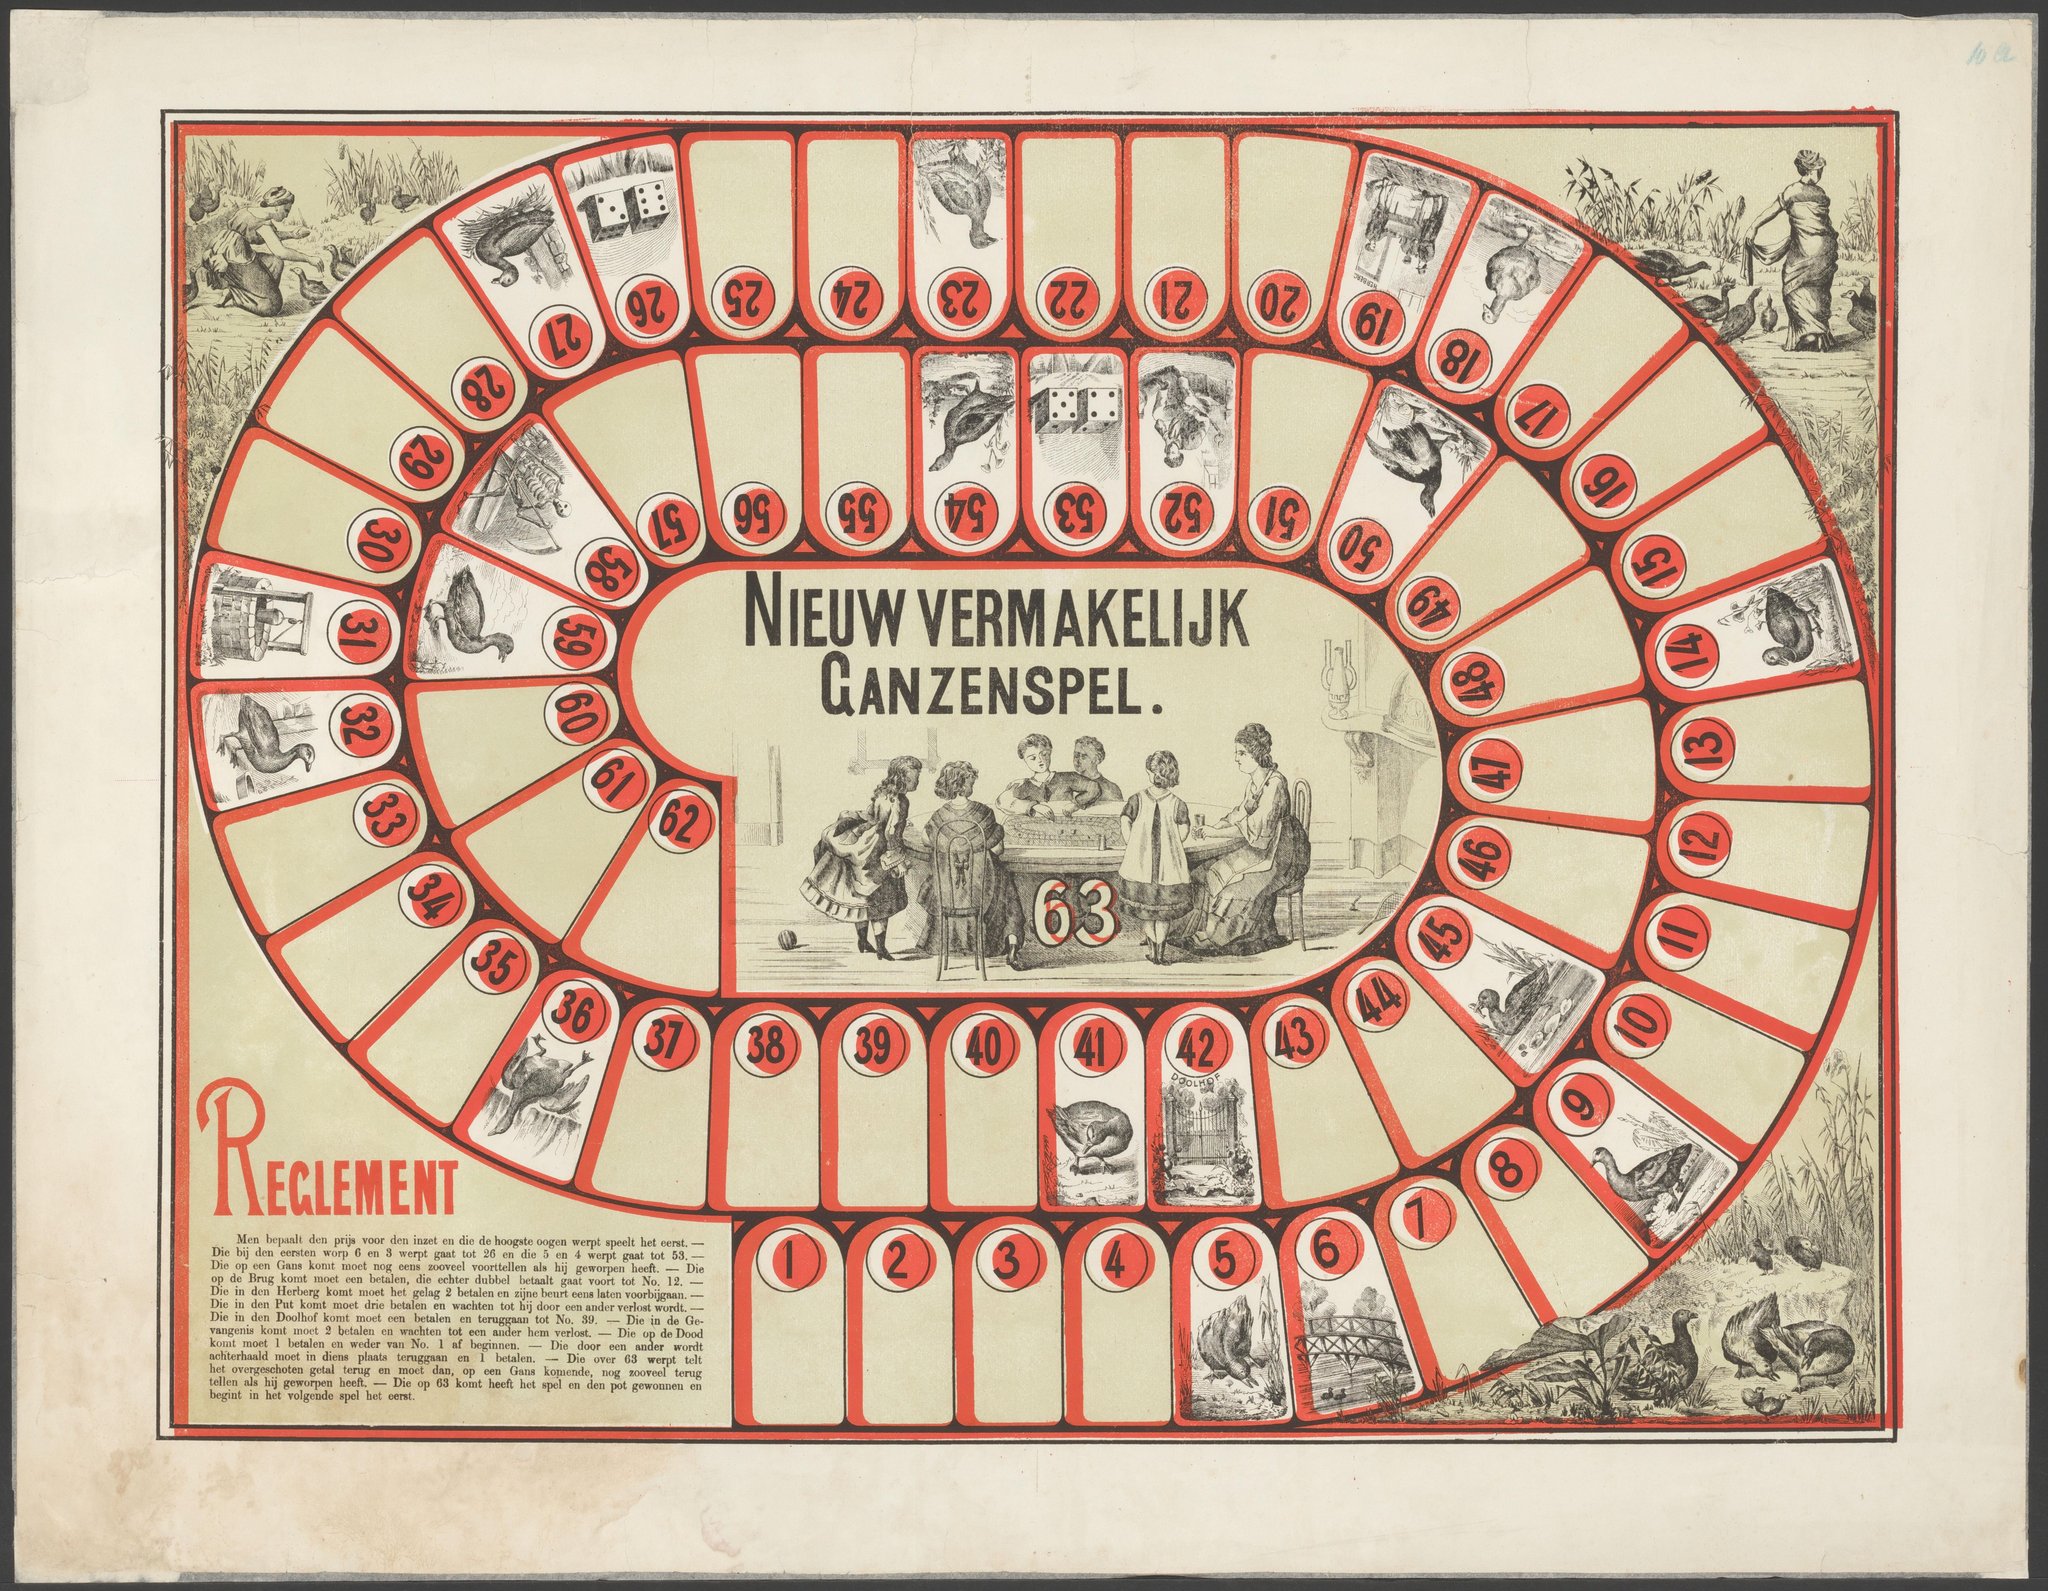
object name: print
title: Speelbord voor ganzenbord met een familie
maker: Anonymous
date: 1850-1899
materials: paper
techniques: letterpress printing, lithograph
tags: goose-game, board-games of chance, board-games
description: Spiraalvormig ganzenbord met 63 vakken. In het midden de titel en een afbeelding van een ganzenbord spelend gezelschap, bestaande uit vijf kinderen en een vrouw. Rechts een schouw. Linksonder de spelregels. Bovenaan ganzenhoedsters met ganzen. Onderwerpsrubrieken binnen de Atlas Zeden en Gewoonten: Zeden en gewoonten in engeren zin, Spel en vermaak, Gezelschapsspel II, Ganzenbord en dergelijke.